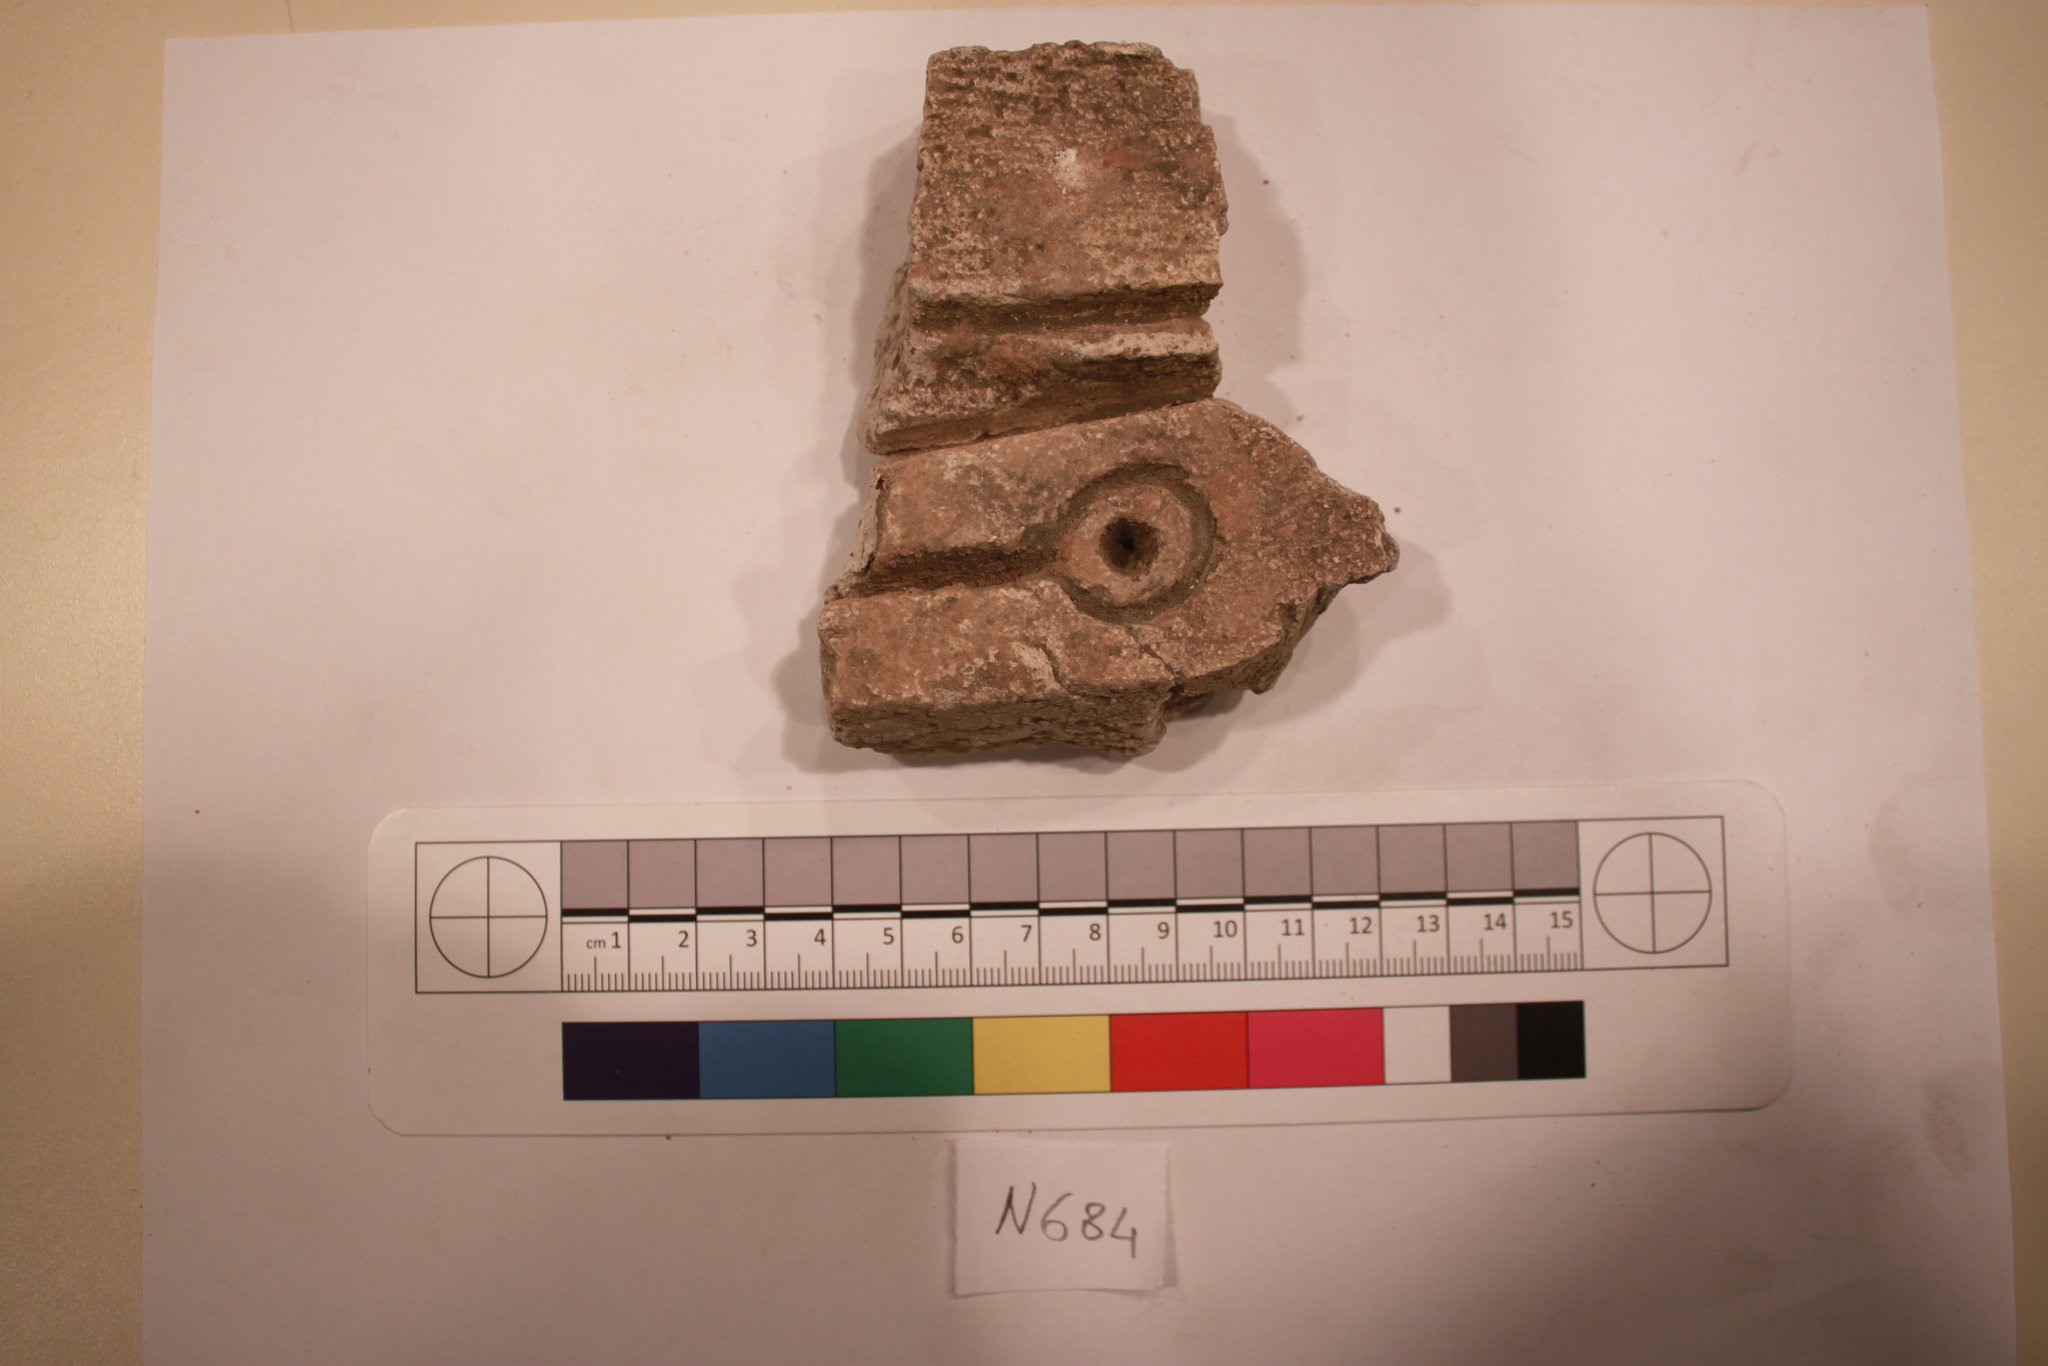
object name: fragment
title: Stucco Fragment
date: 701-1200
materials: plaster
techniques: carving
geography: iran